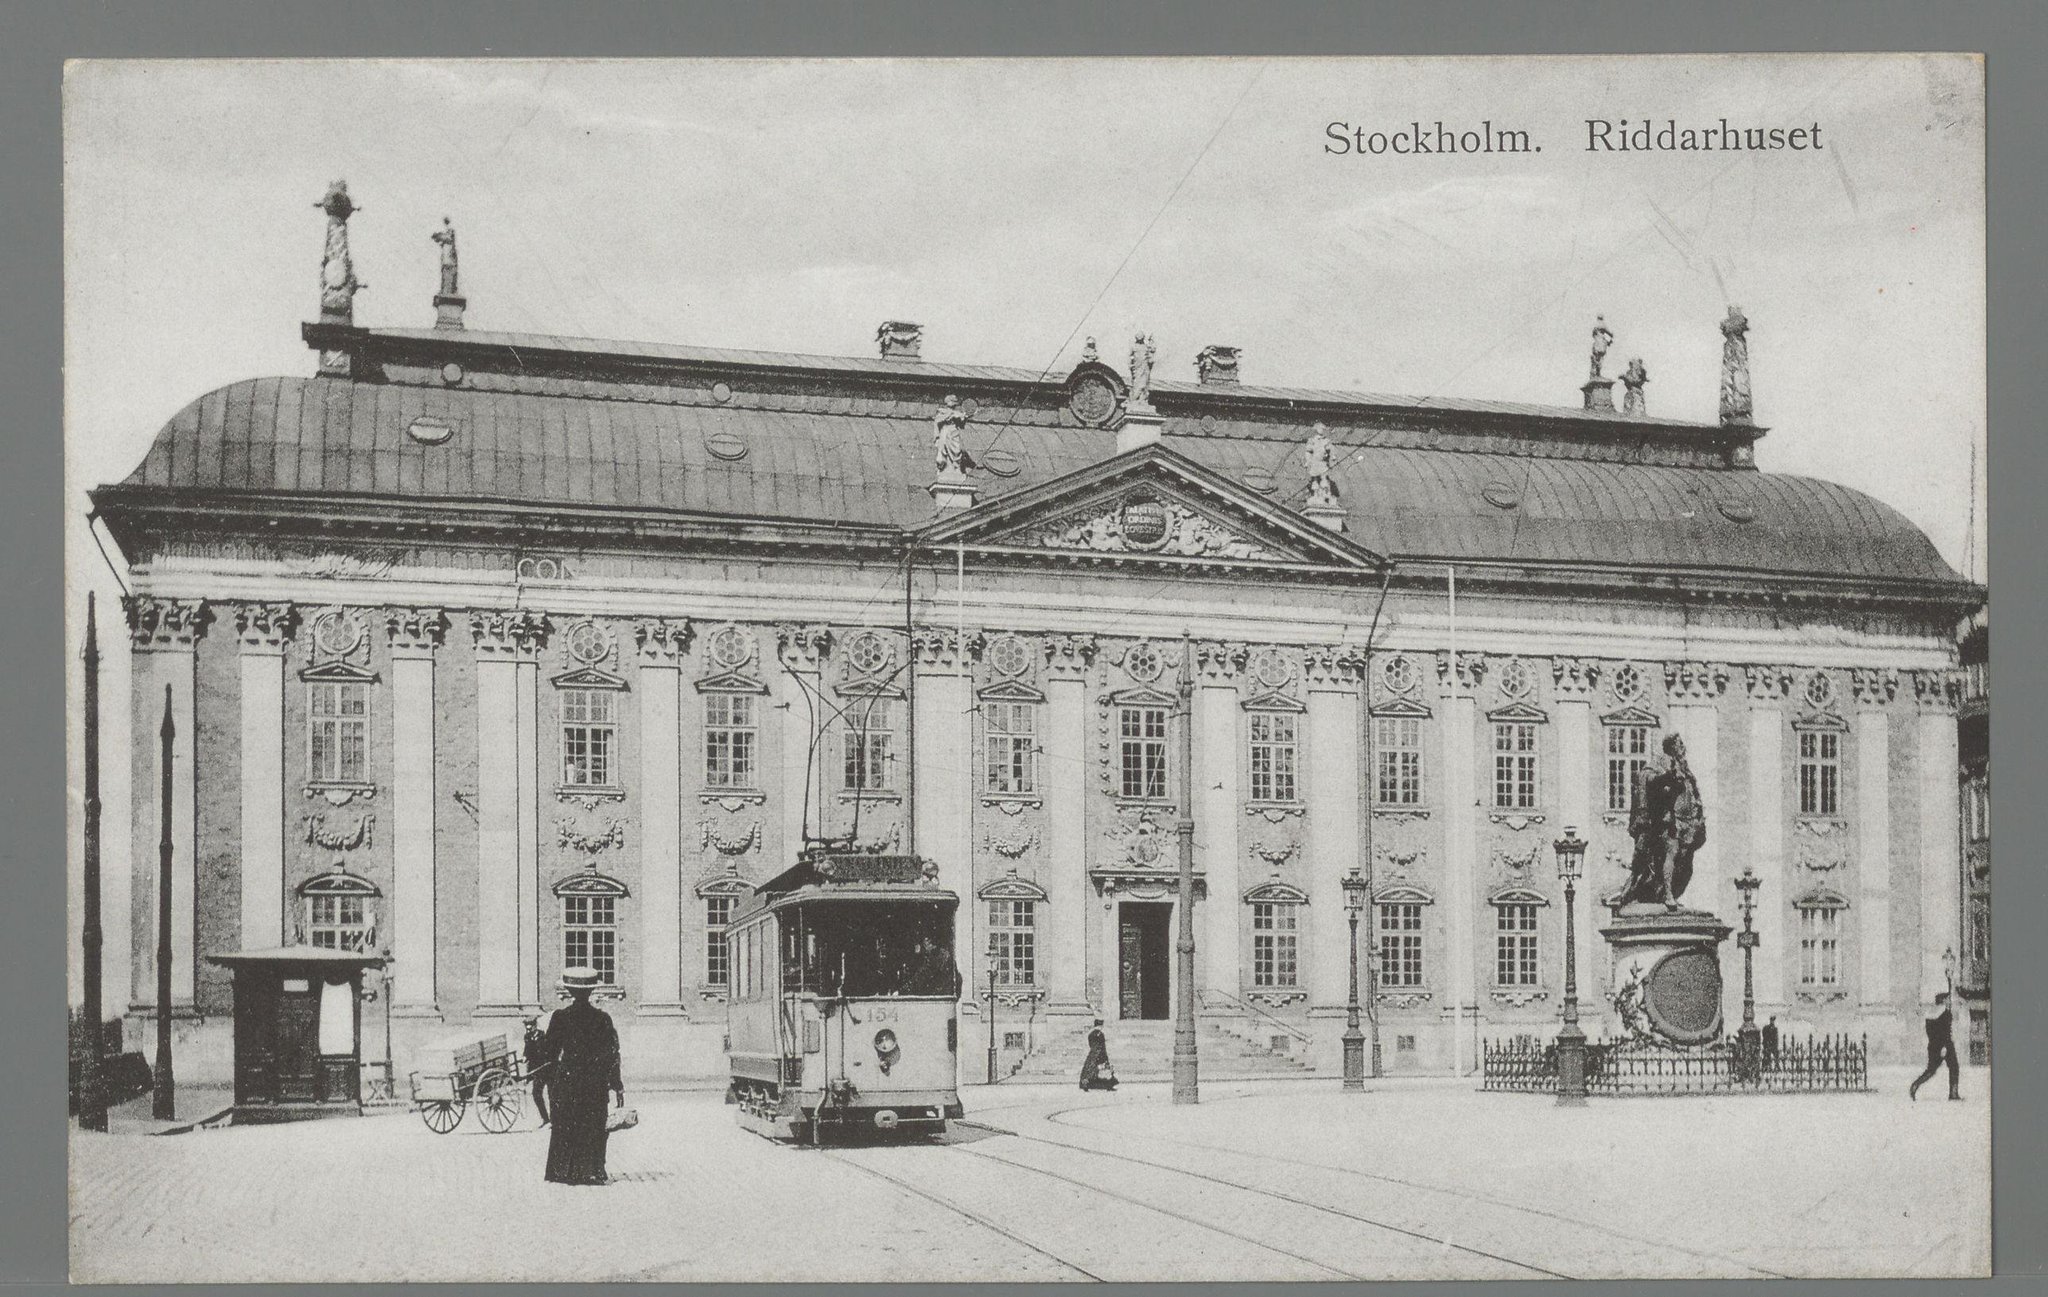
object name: photomechanical print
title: Stockholm. Riddarhuset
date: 1905-1930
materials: cardboard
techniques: photograph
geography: stockholm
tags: tram, monument, statue, edifice, e.g.: public building, department store